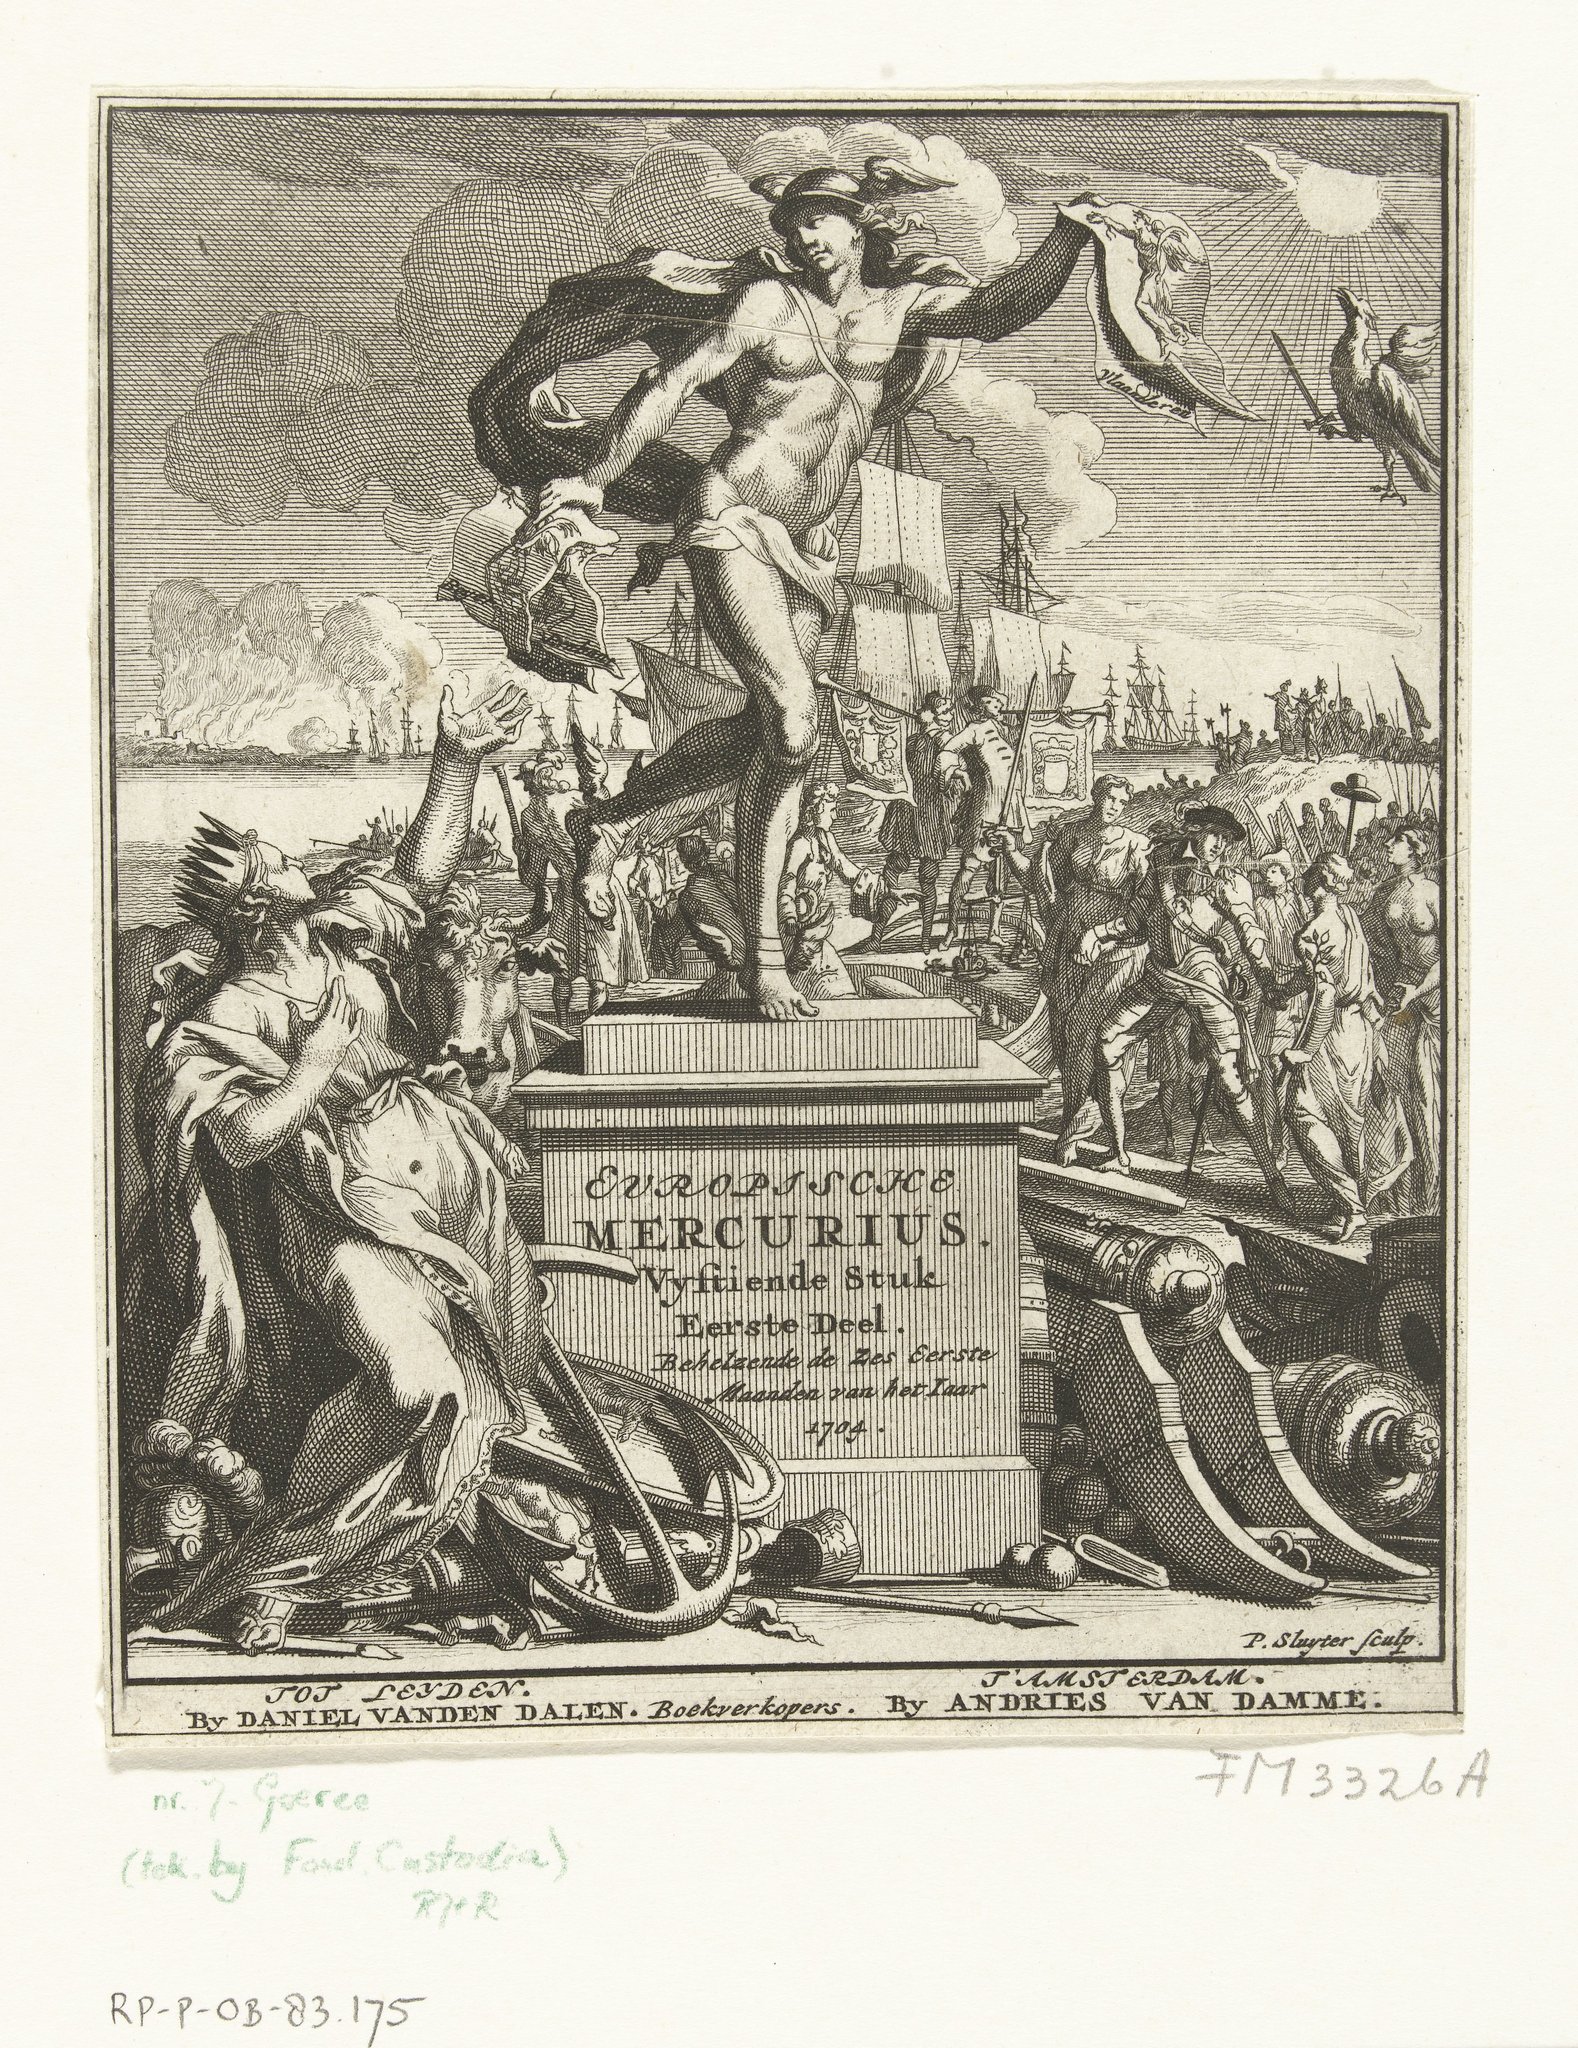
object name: print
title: Titelpagina voor de Europische Mercurius, vijftiende stuk, eerste deel, 1704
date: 1704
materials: paper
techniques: etching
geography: amsterdam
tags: specific aspects, allegorical aspects of mercury; mercury as patron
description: Titelpagina voor de Europische Mercurius, vijftiende stuk, eerste deel, behelzende de eerste zes maanden van het jaar 1704. Mercurius staande op een voetstuk, reikt bladen papier met de namen van Beieren en Brabant aan een allegorische vrouwenfiguur (Vrijheid?), het blad met Vlaanderen nog in de lucht.